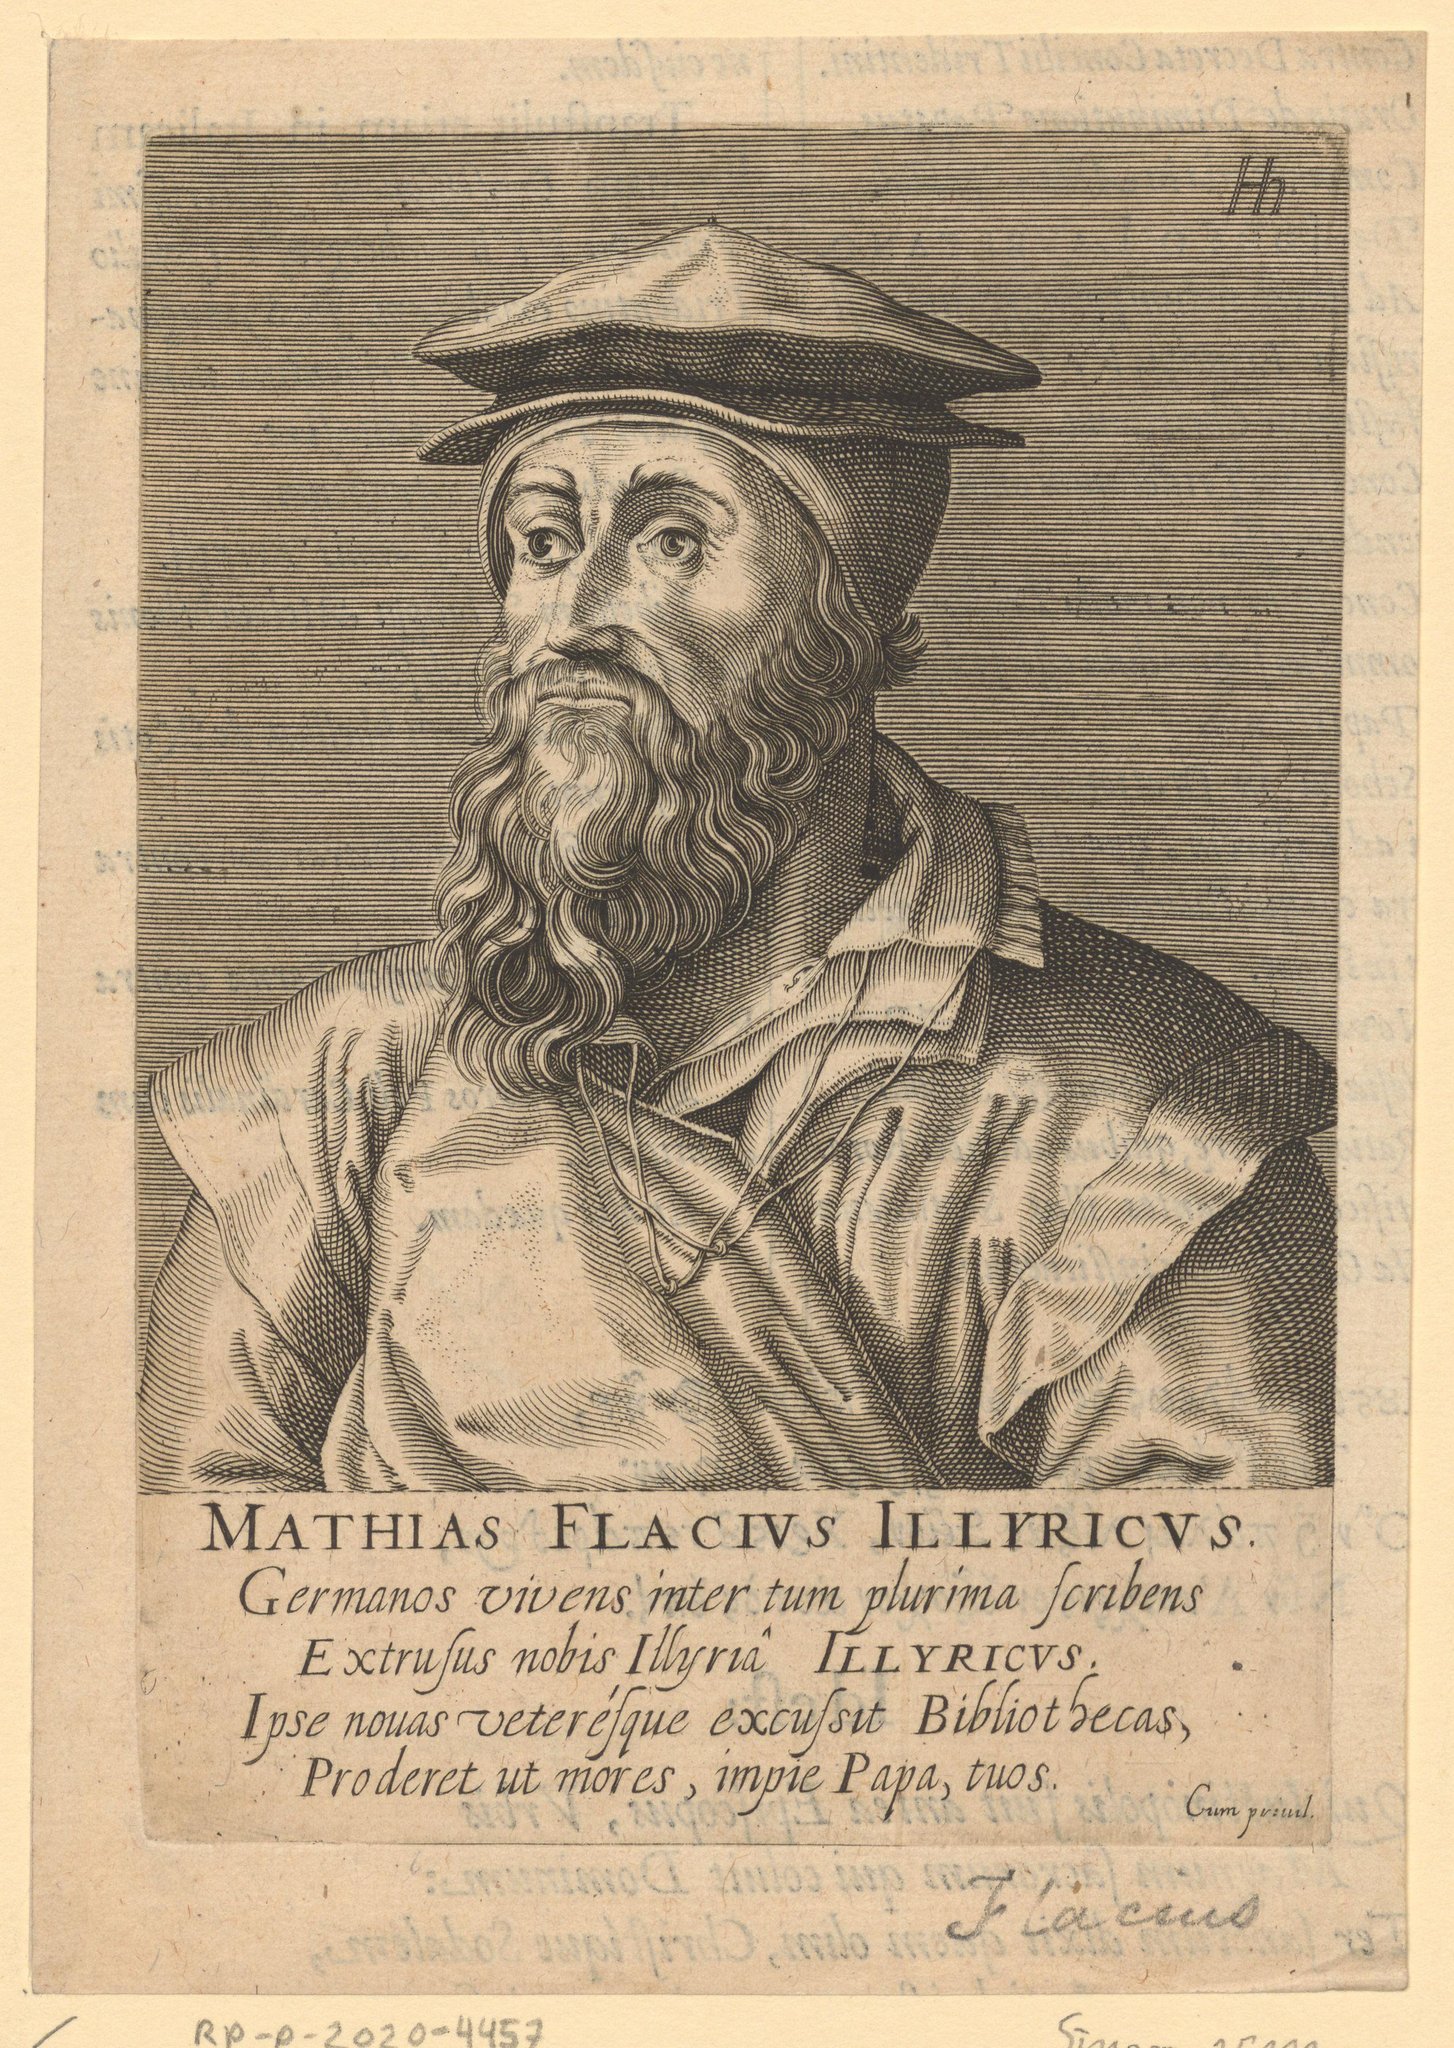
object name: print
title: Portret van Matthias Flacius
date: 1602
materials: paper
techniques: engraving, letterpress printing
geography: the hague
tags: theologian, historical persons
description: Prent uit: Verheiden, Jacob. Præstantium aliquot theologorum (...). Den Haag: Hendrick Hondius I en Beukel Cornelisz. Nieulandt, 1602. Prent is ook verschenen in publicaties uit 1599, 1603 en 1604.